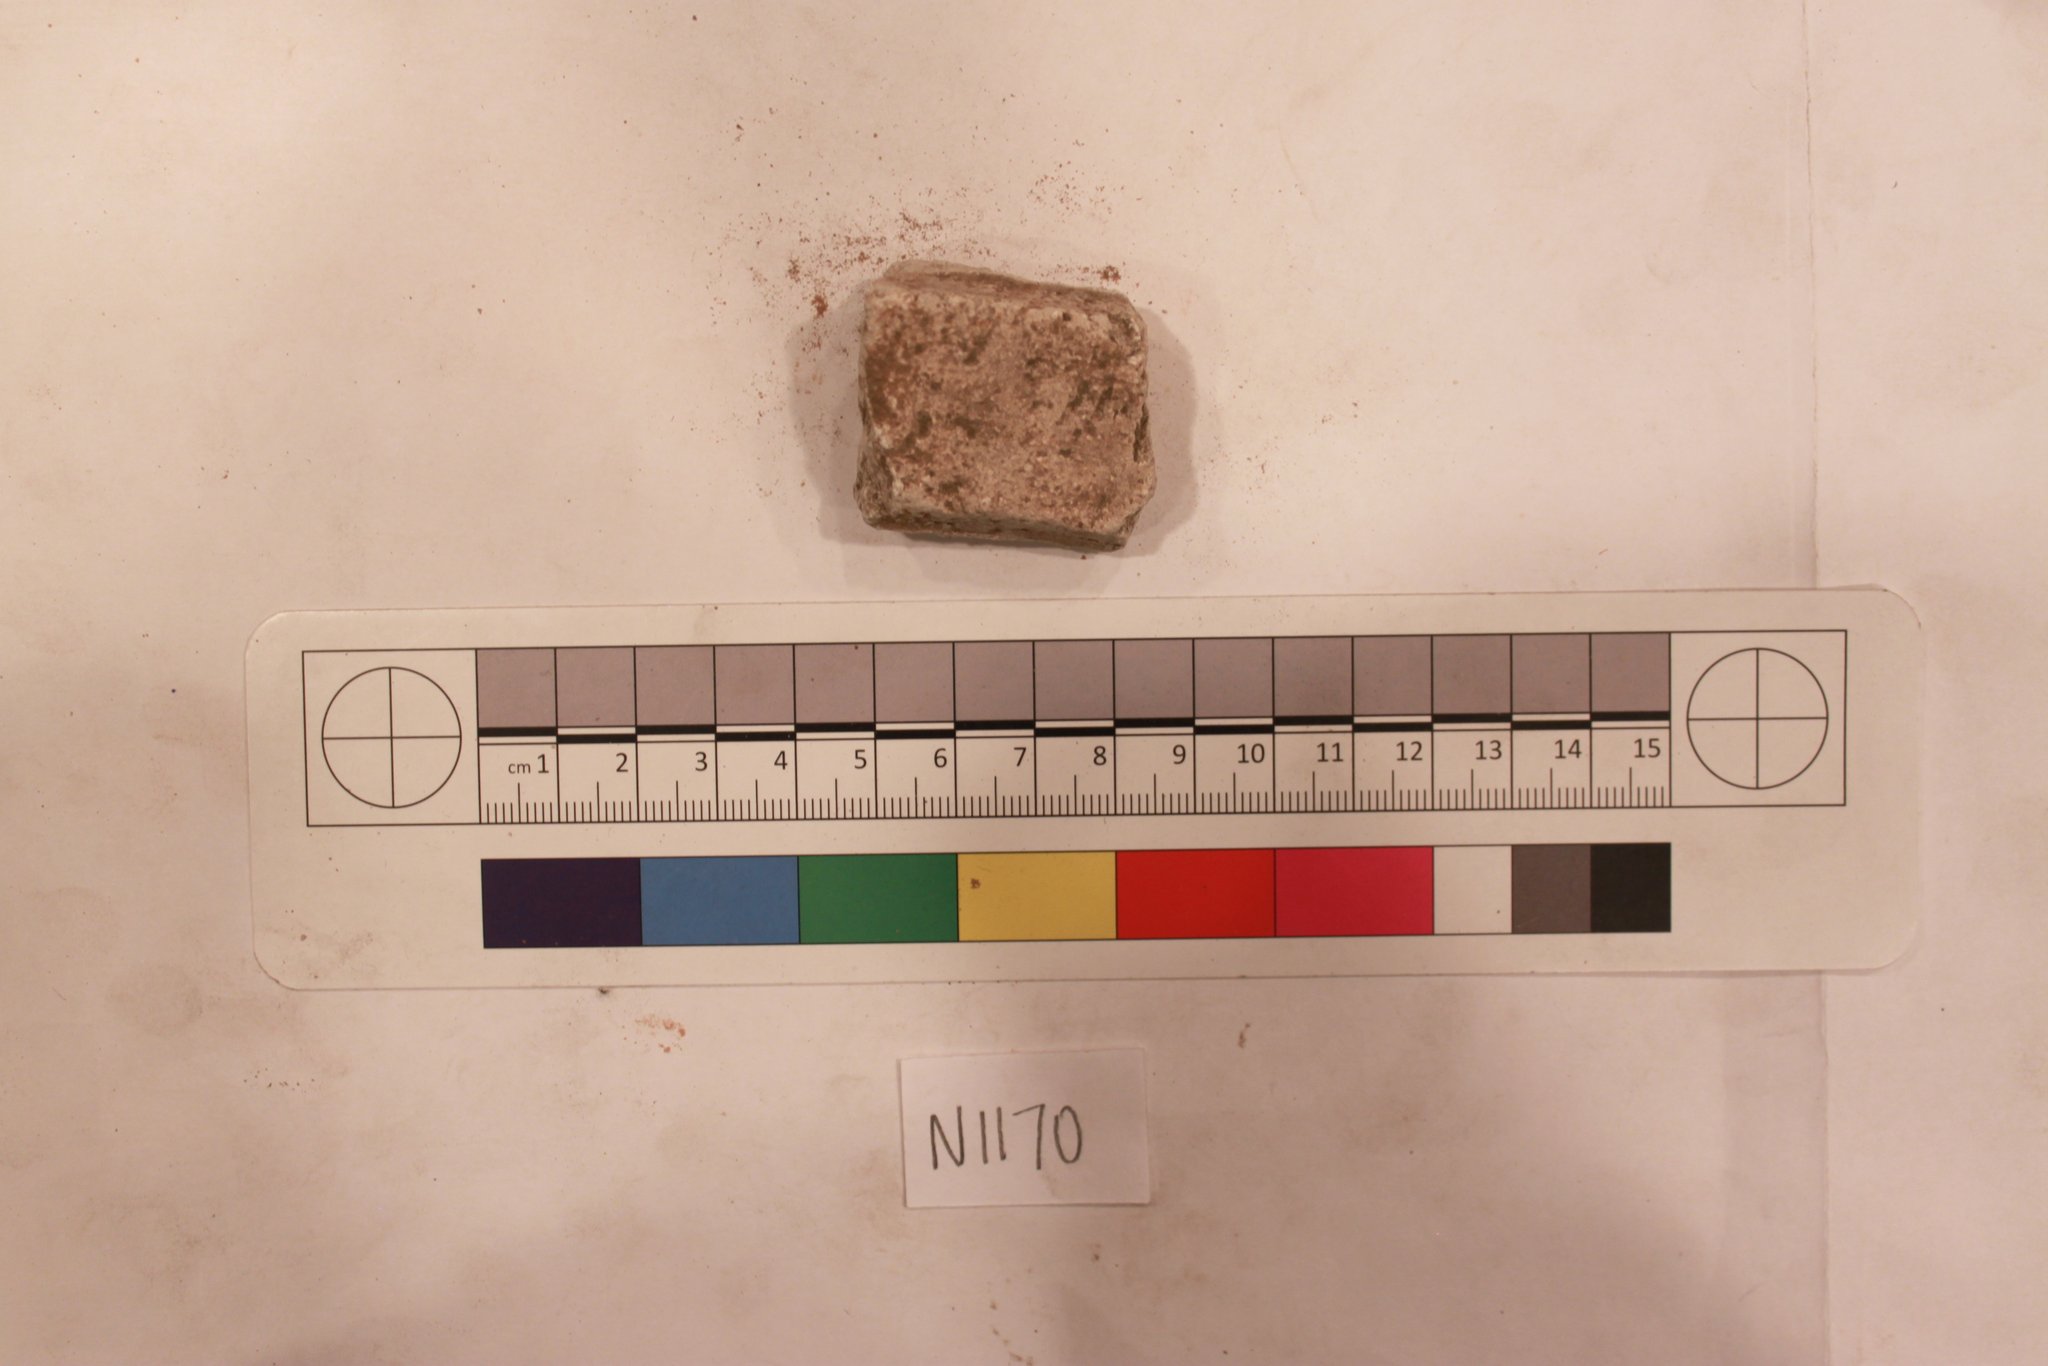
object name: fragment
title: Stucco Fragment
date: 701-1200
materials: plaster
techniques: carving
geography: iran